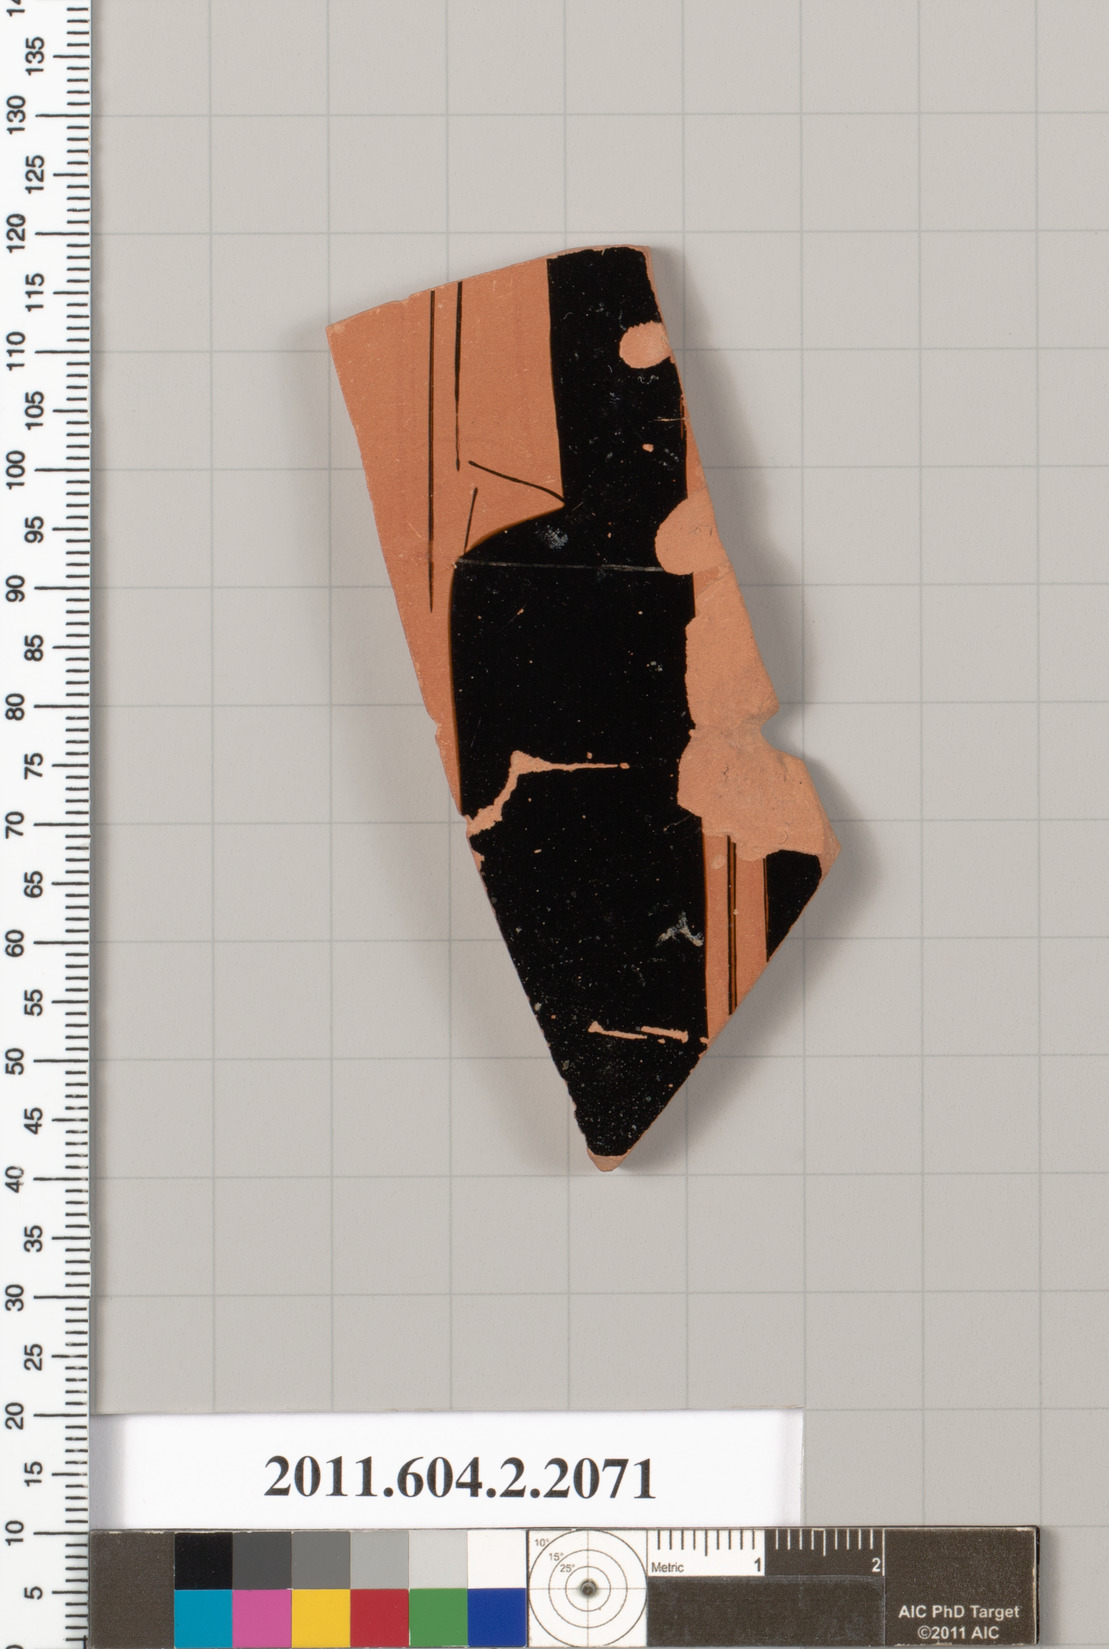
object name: neck amphora fragment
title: Terracotta fragment of a neck-amphora (jar)?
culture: greek, attic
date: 450-440 BCE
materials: terracotta